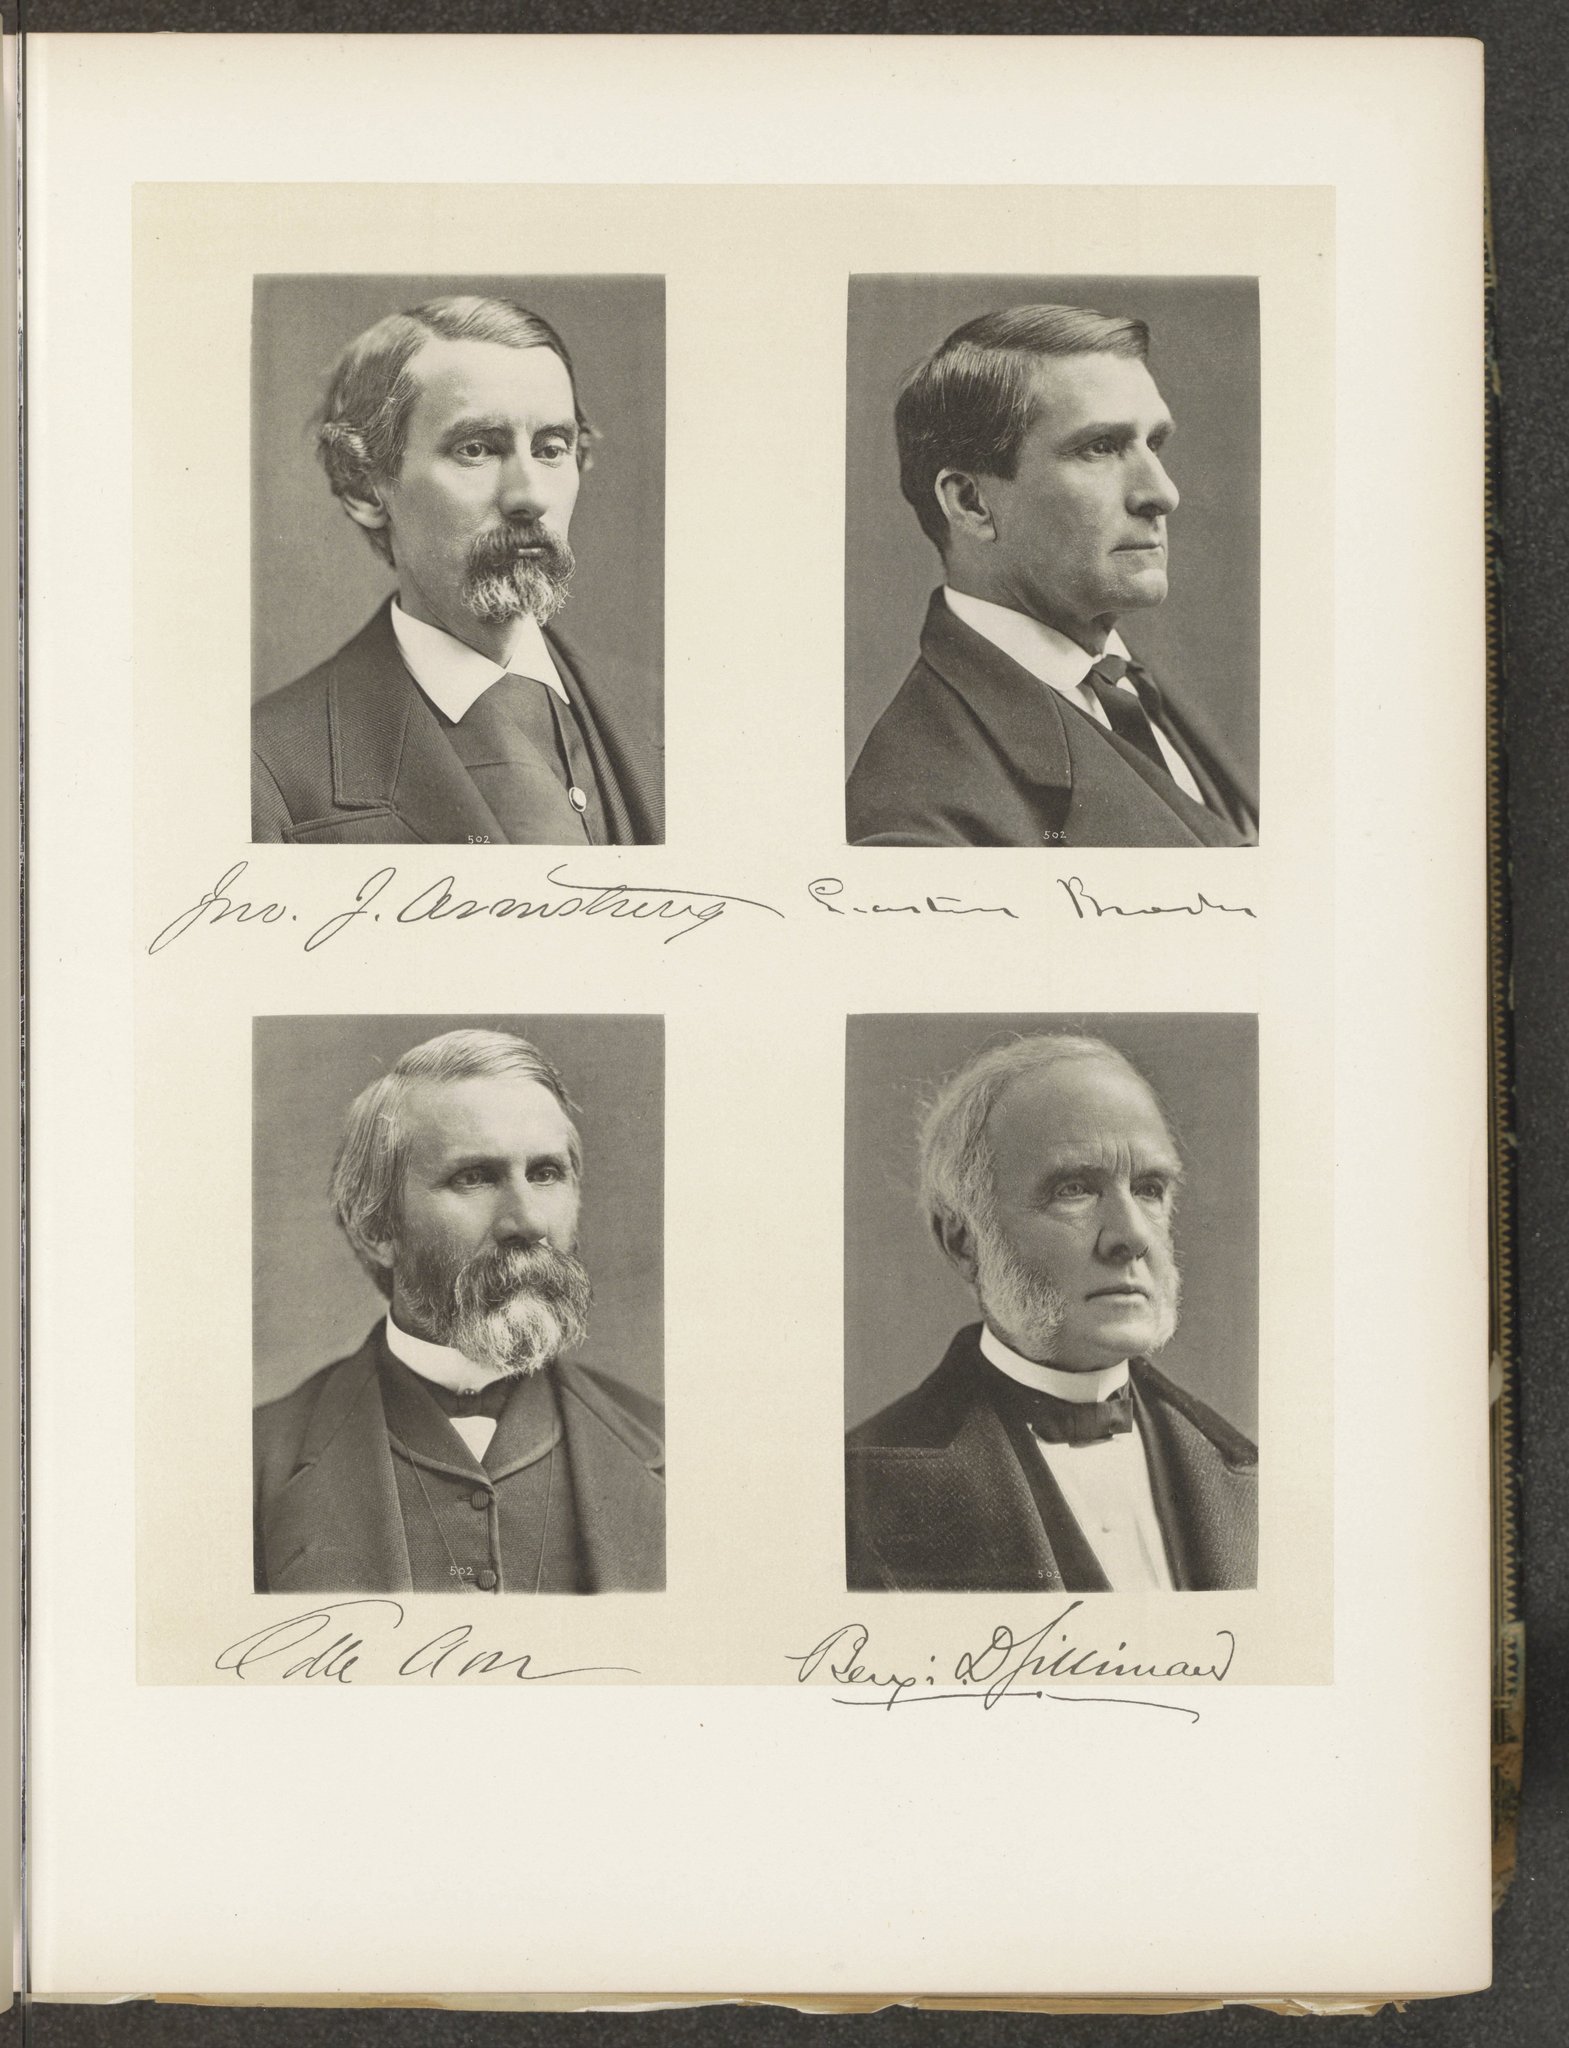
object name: page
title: Vier portretten van leden van de Constitutionele Commissie van de staat New York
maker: Anonymous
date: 1872-1882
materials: paper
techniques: photograph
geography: united states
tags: historical persons (+ head (and shoulders) (portrait))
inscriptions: number: ‘502’, annotation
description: Linksboven John J. Armstrong, rechtsboven Erastus Brooks, linksonder Odle Close, rechtsonder Benjamin J. Silliman.